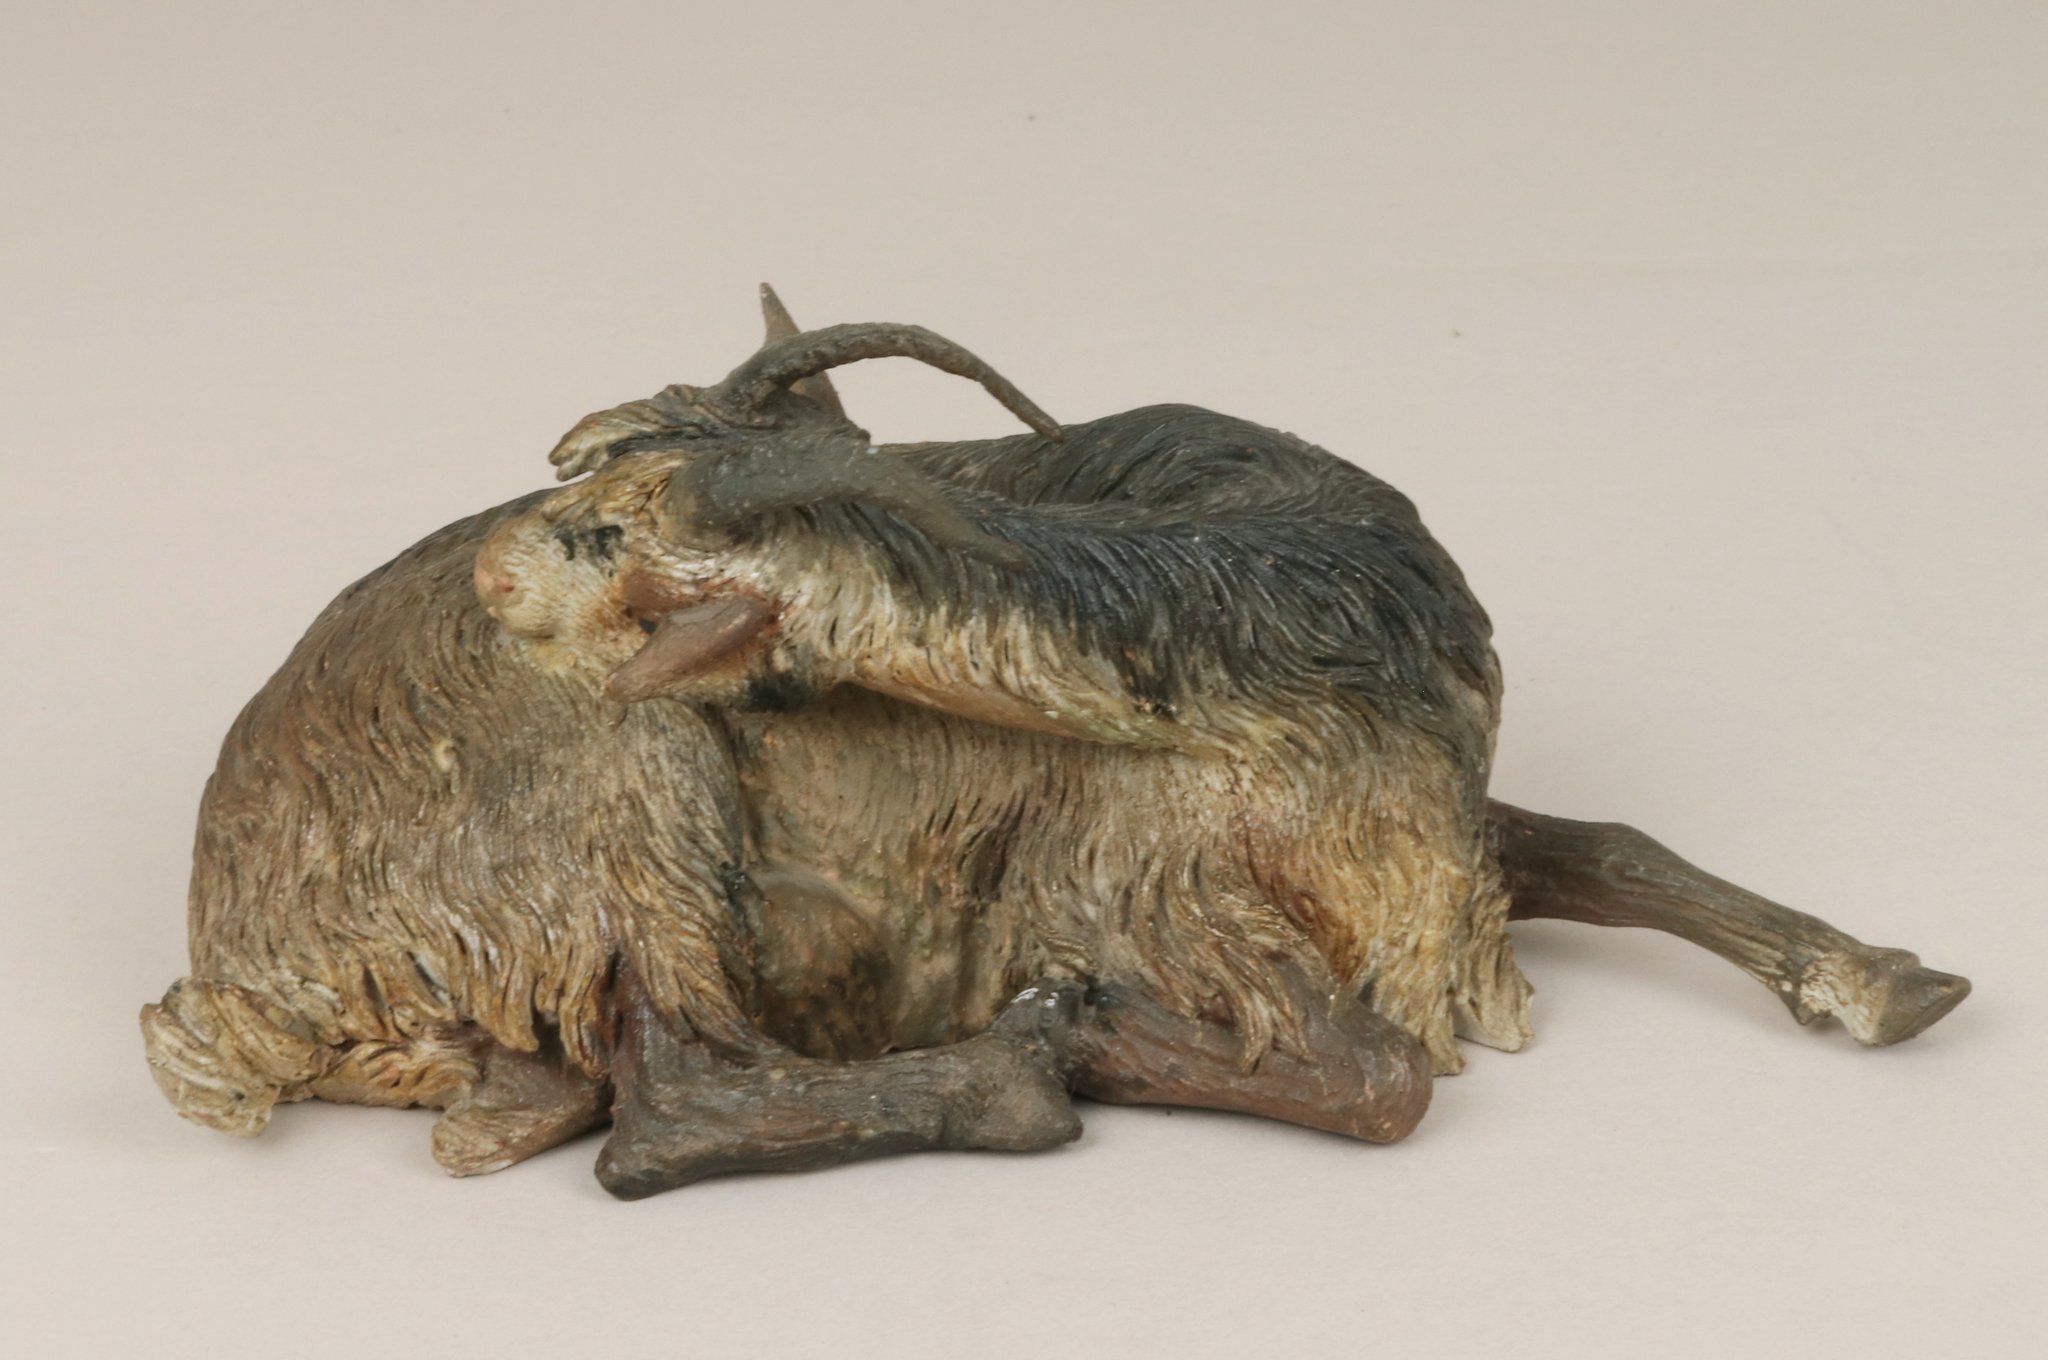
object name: crèche figure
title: Seated goat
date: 1701-1800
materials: terracotta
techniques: polychrome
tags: goats